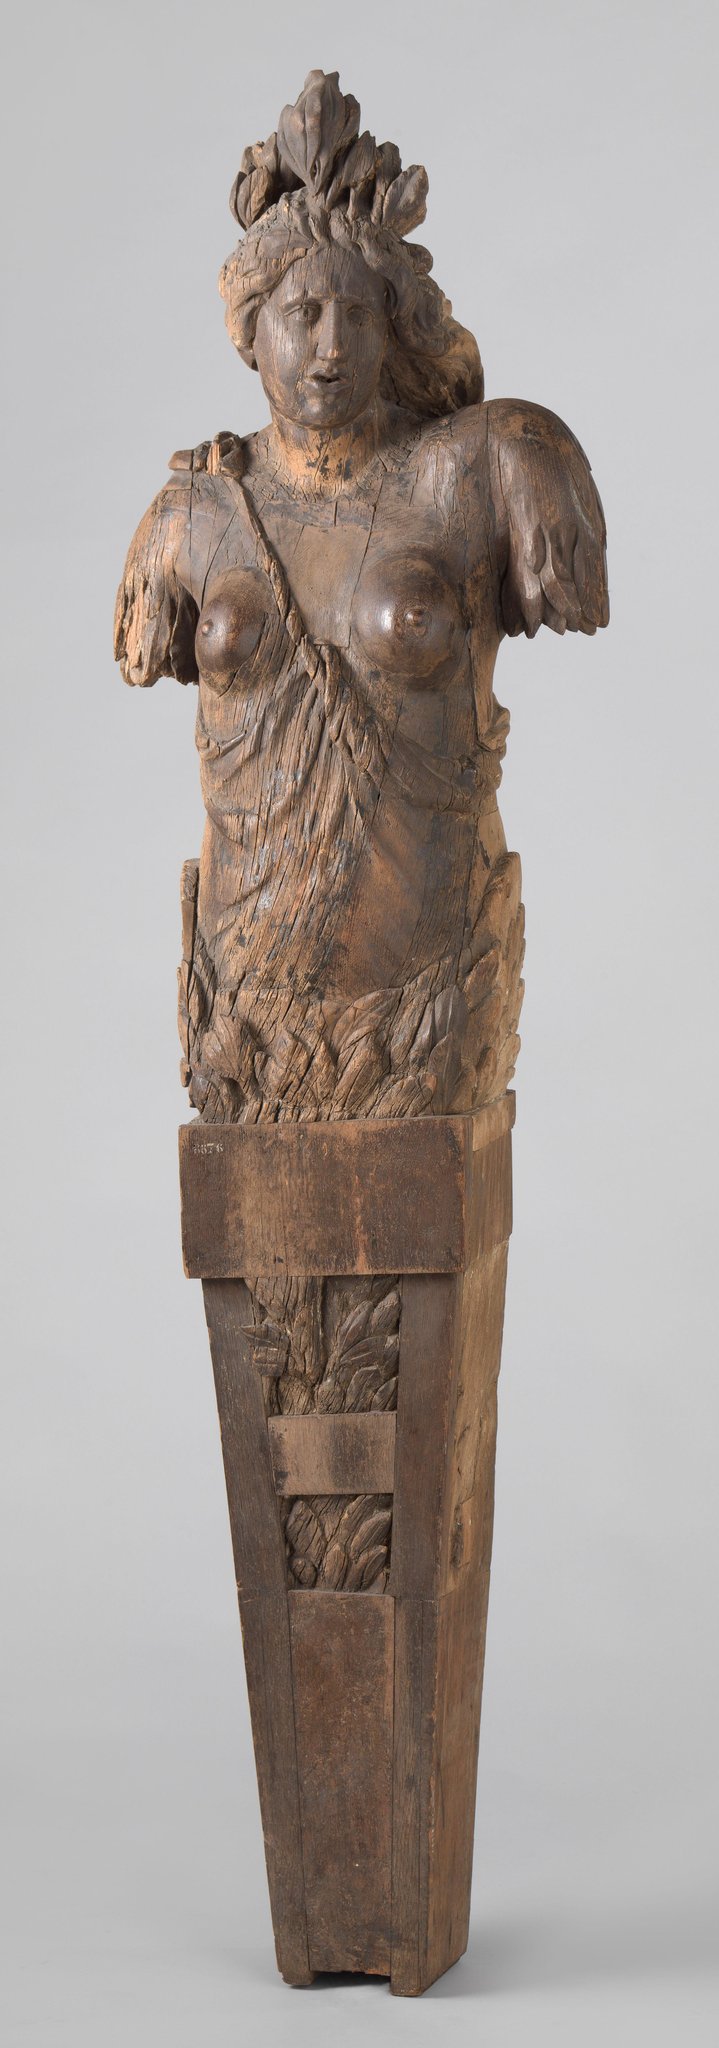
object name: sculpture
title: Female Terminal Figure (Flora ?)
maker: Anonymous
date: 1700-1725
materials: wood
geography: northern netherlands